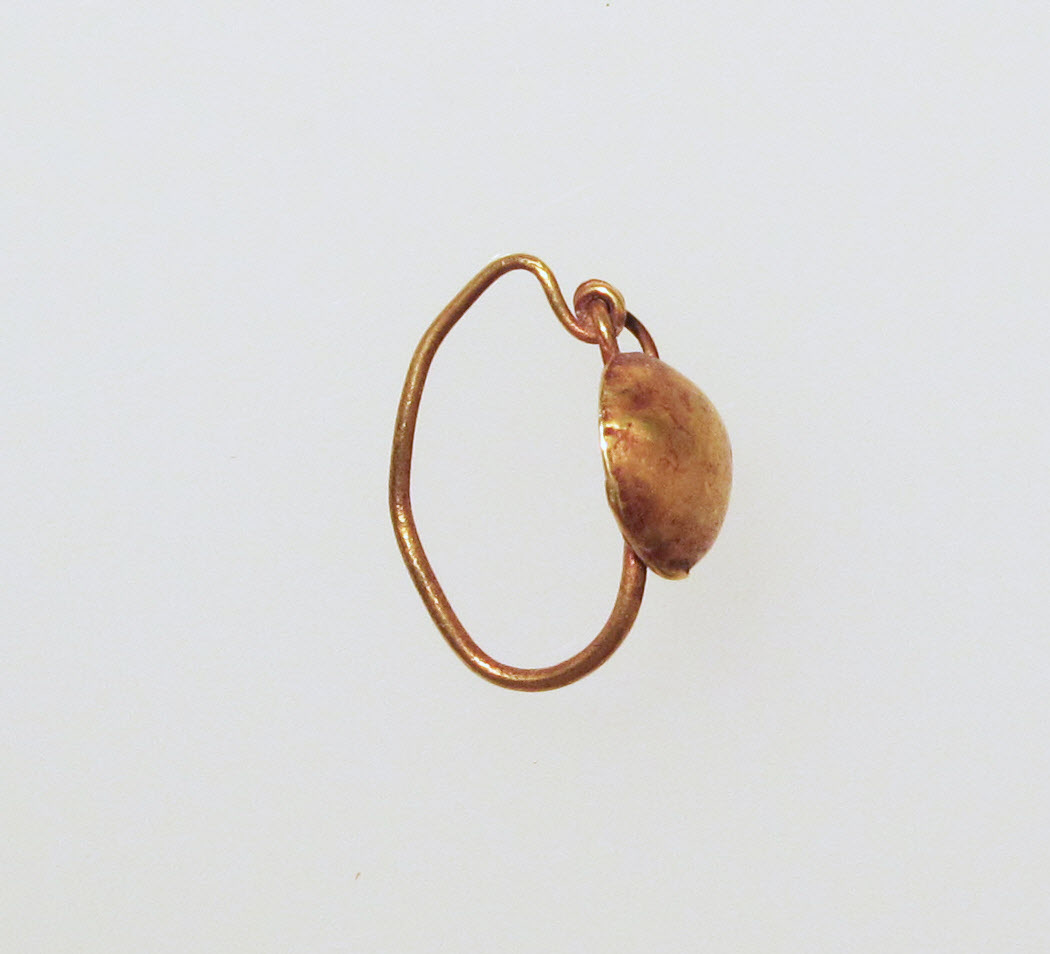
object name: earring with plain loop and disc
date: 7000 BCE-330 CE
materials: gold